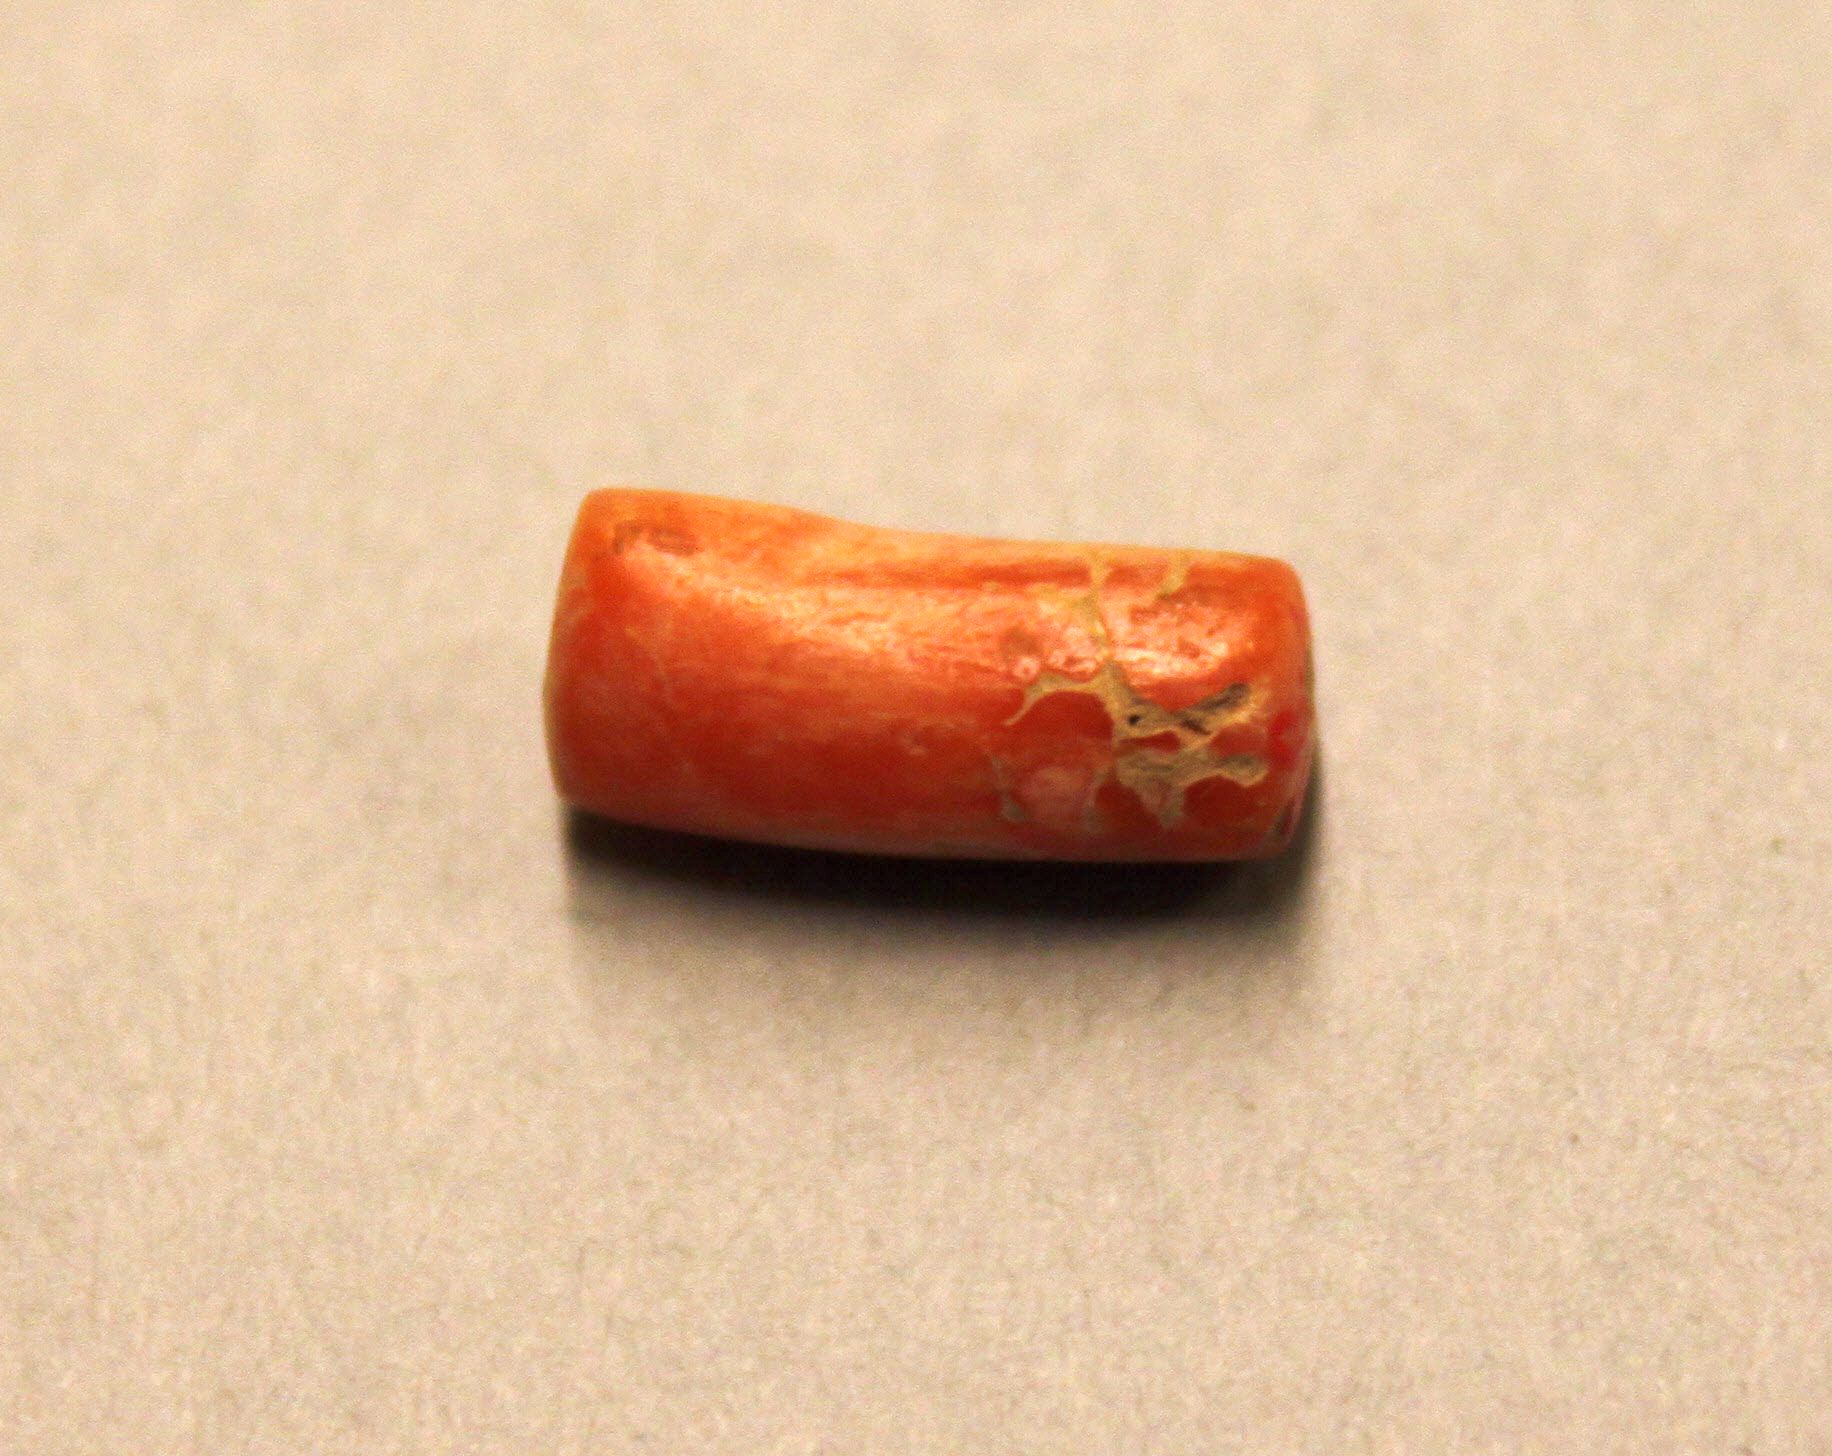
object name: bead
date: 701-1200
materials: stone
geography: iran